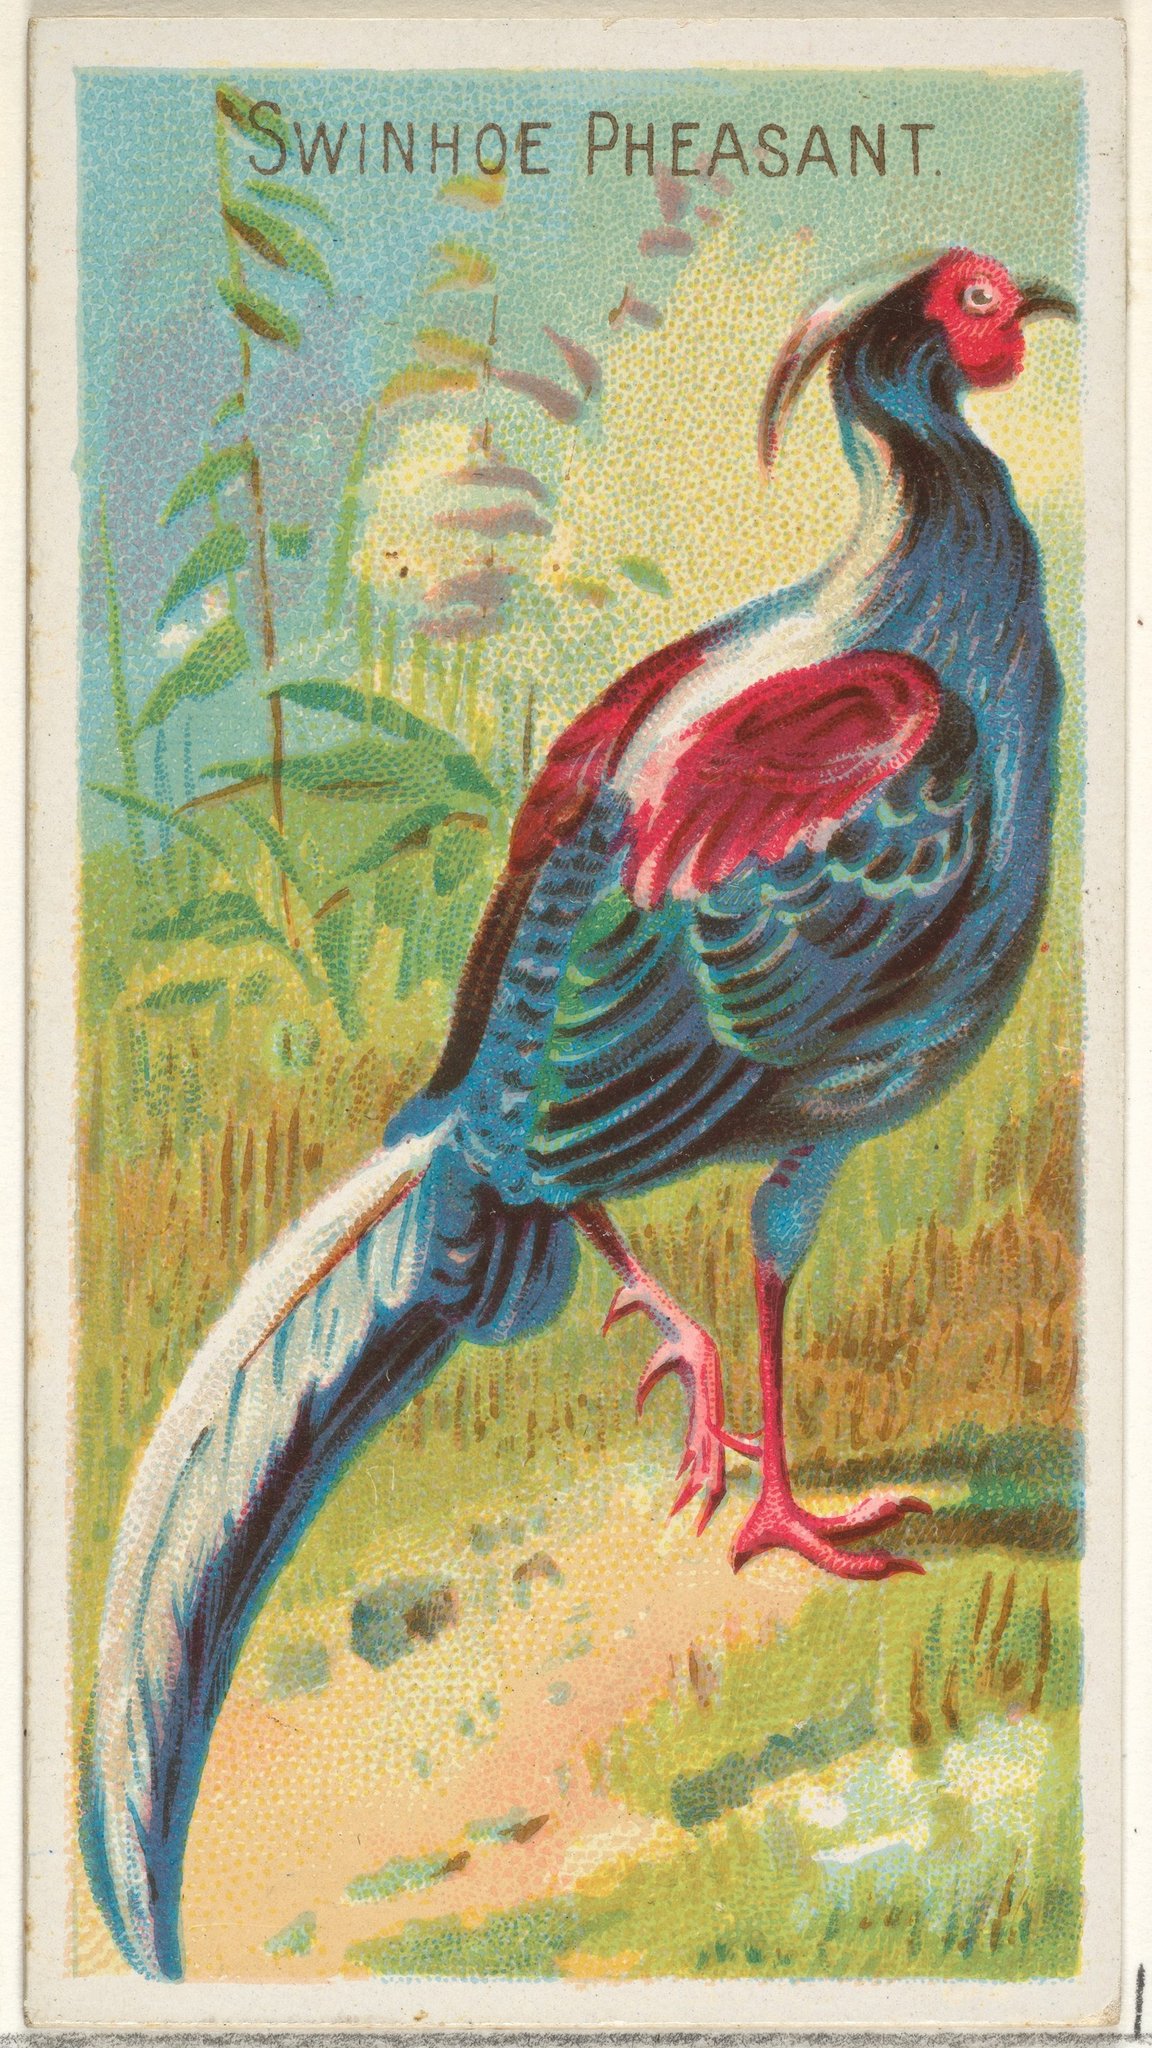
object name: print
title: Swinhoe Pheasant, from the Birds of the Tropics series (N5) for Allen & Ginter Cigarettes Brands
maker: allen & ginter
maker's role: publisher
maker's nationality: american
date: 1889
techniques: color lithograph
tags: pheasants